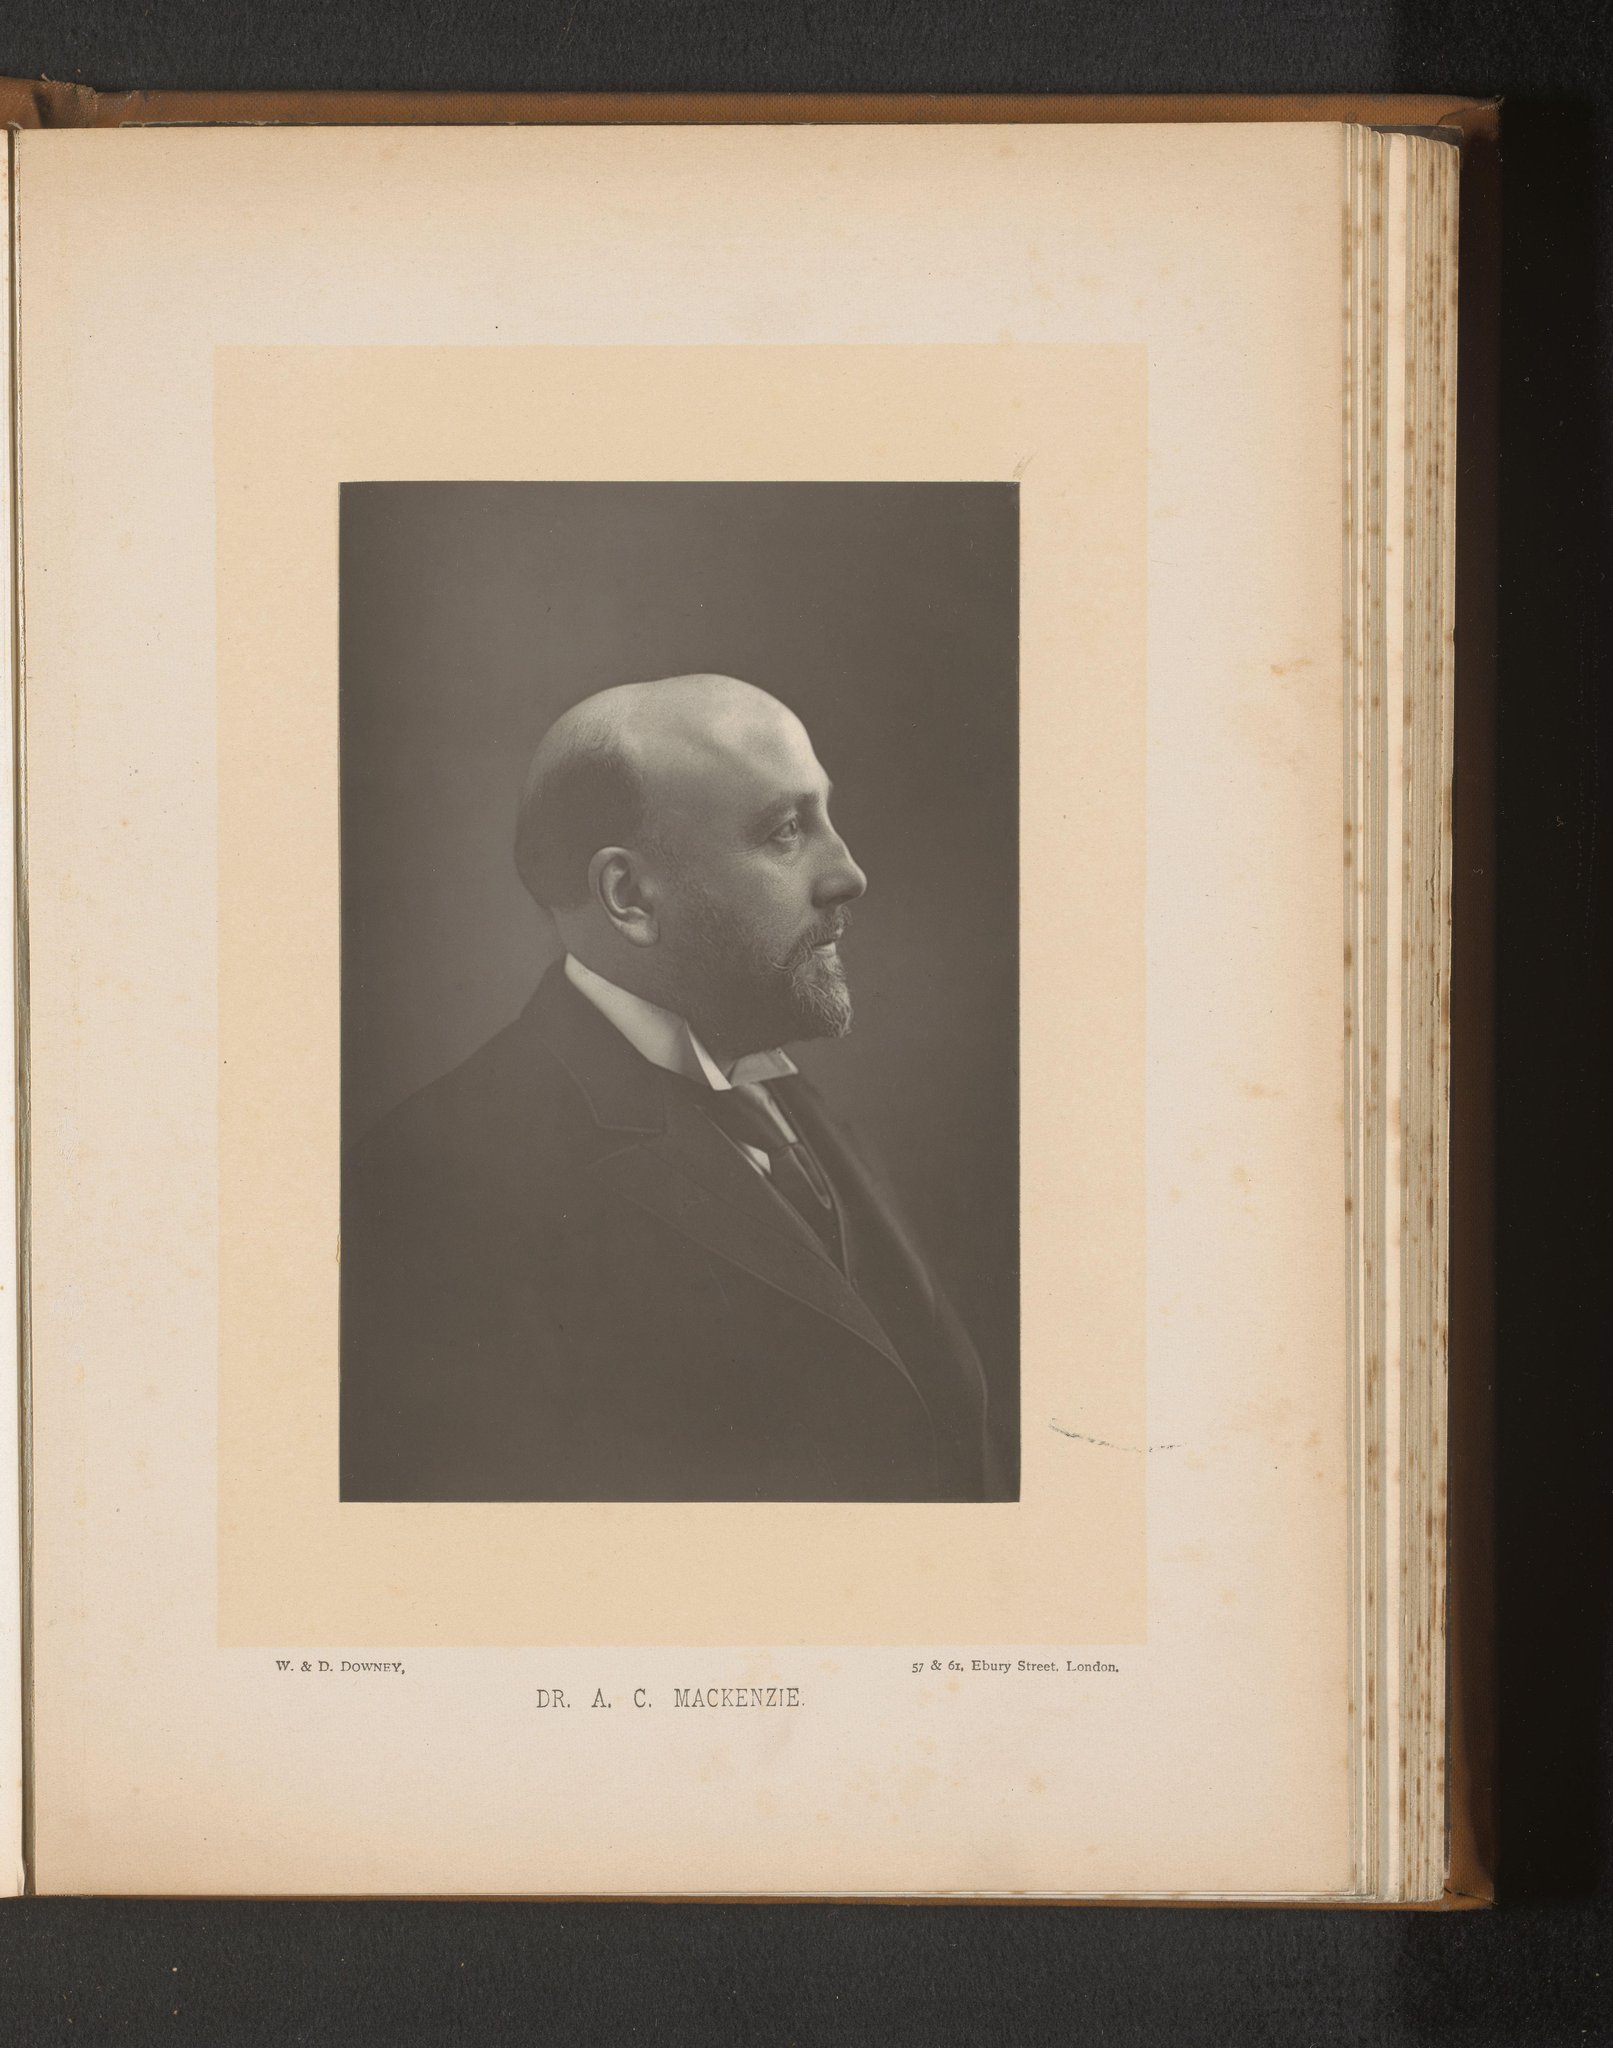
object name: photomechanical print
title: Portret van Alexander Mackenzie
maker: Anonymous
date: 1884-1894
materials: paper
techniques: woodburytype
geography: london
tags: composer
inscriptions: inscription: ‘57 & 61, Elbury Street, London.’